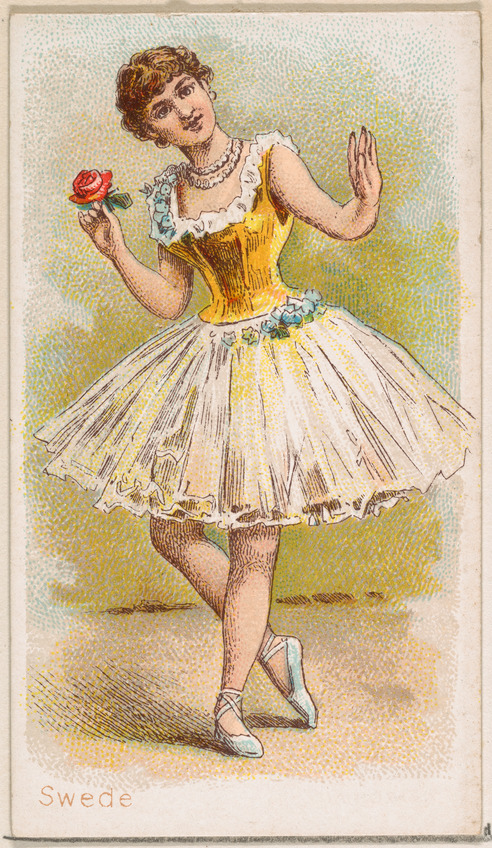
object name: print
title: Swedish Dancer, from the Dancing Women series (N186) issued by Wm. S. Kimball & Co.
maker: william s. kimball & company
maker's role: publisher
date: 1889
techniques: color lithograph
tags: women,dancing,dancers